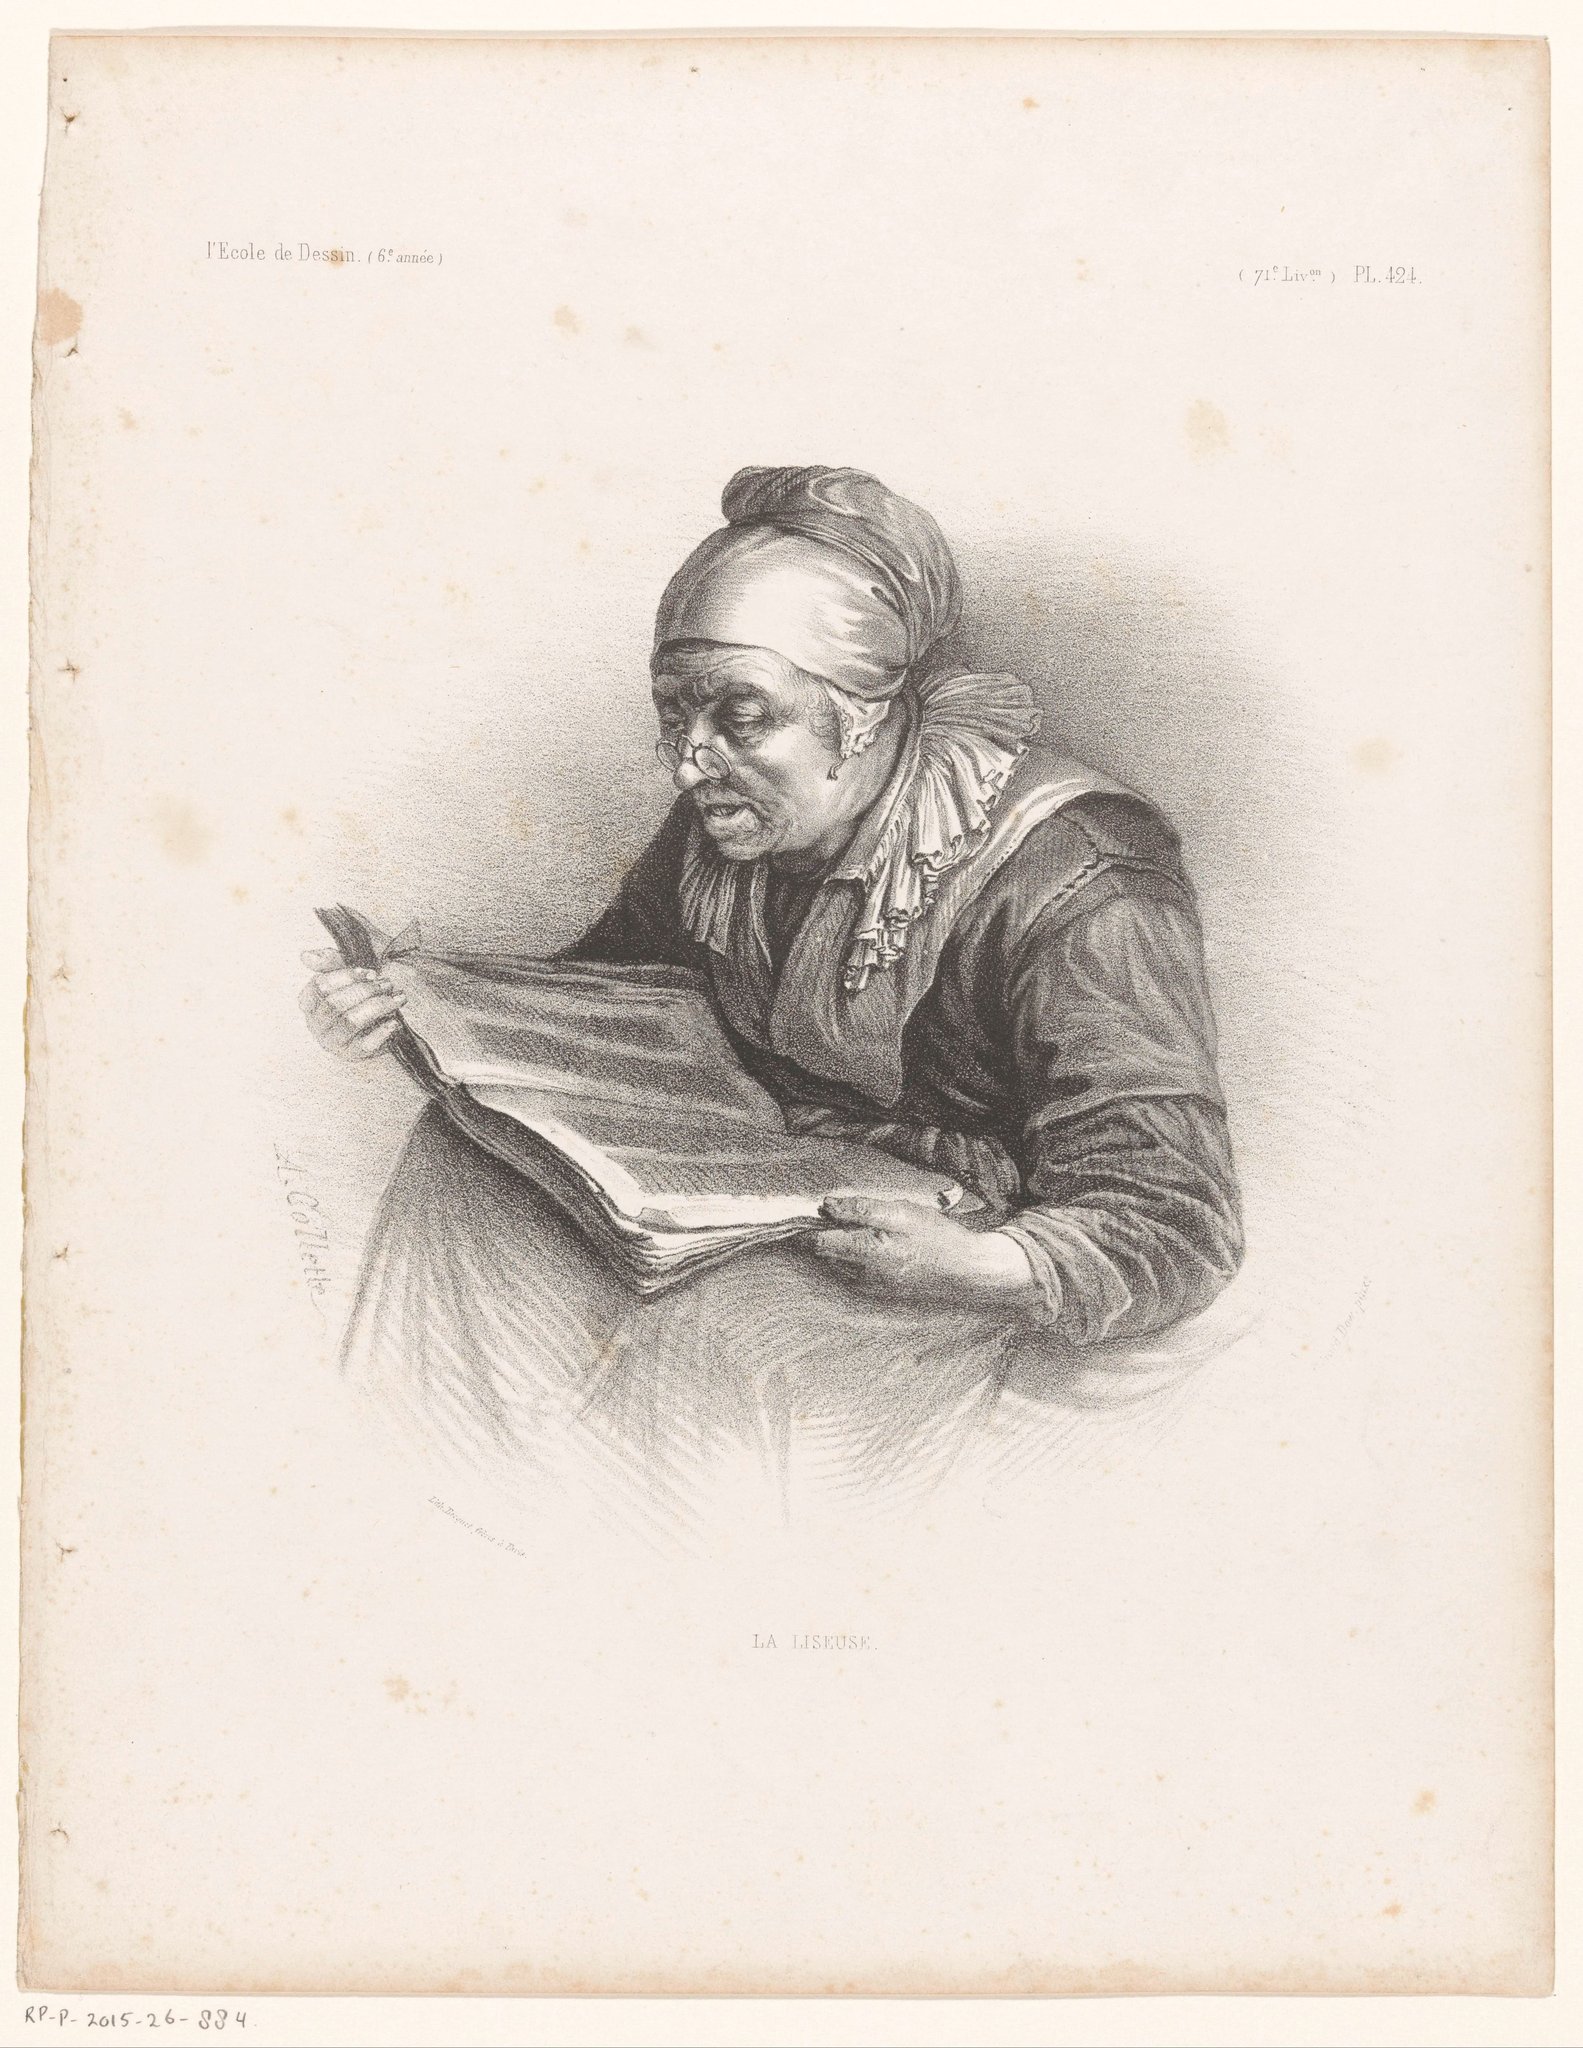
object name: illustration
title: Oude lezende vrouw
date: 1856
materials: paper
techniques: lithograph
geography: paris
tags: old woman, newspaper, news-sheet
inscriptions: collector's mark: Lugt 4780, collector's mark: Lugt 2228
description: Prent afkomstig uit: Album de l'École de dessin: journal des jeunes artistes et des amateurs. Parijs: Au bureau du Journal, [1856].